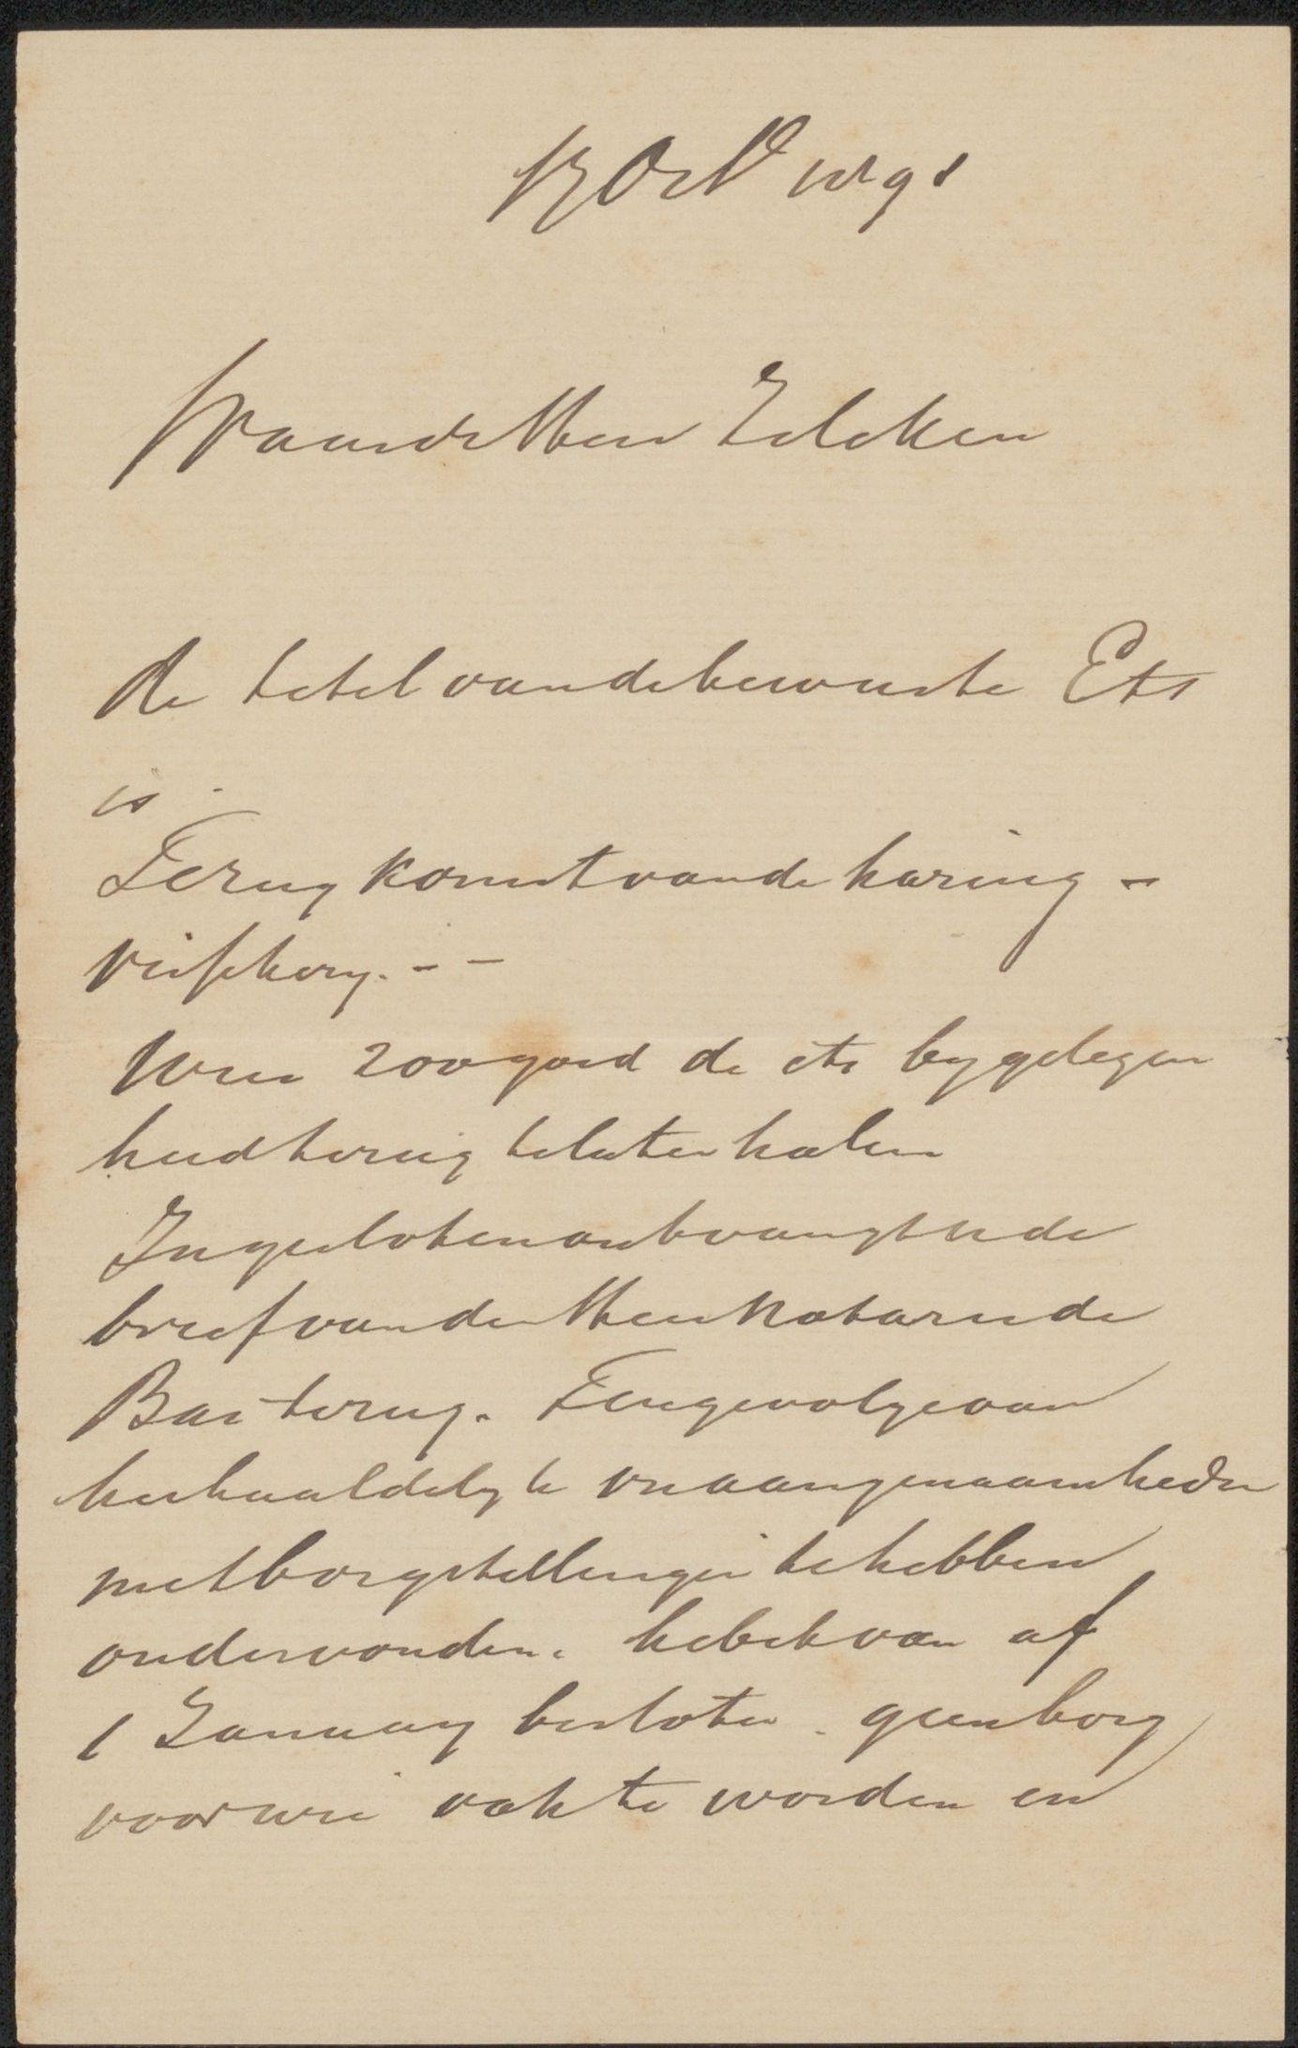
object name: postcard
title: Briefkaart aan Philip Zilcken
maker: hendrik willem mesdag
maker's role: draughtsman, painter, print maker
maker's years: 1831-1915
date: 1898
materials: cardboard, ink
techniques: pen, writing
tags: the hague, draughtsman, philip zilcken, the graphic arts, money